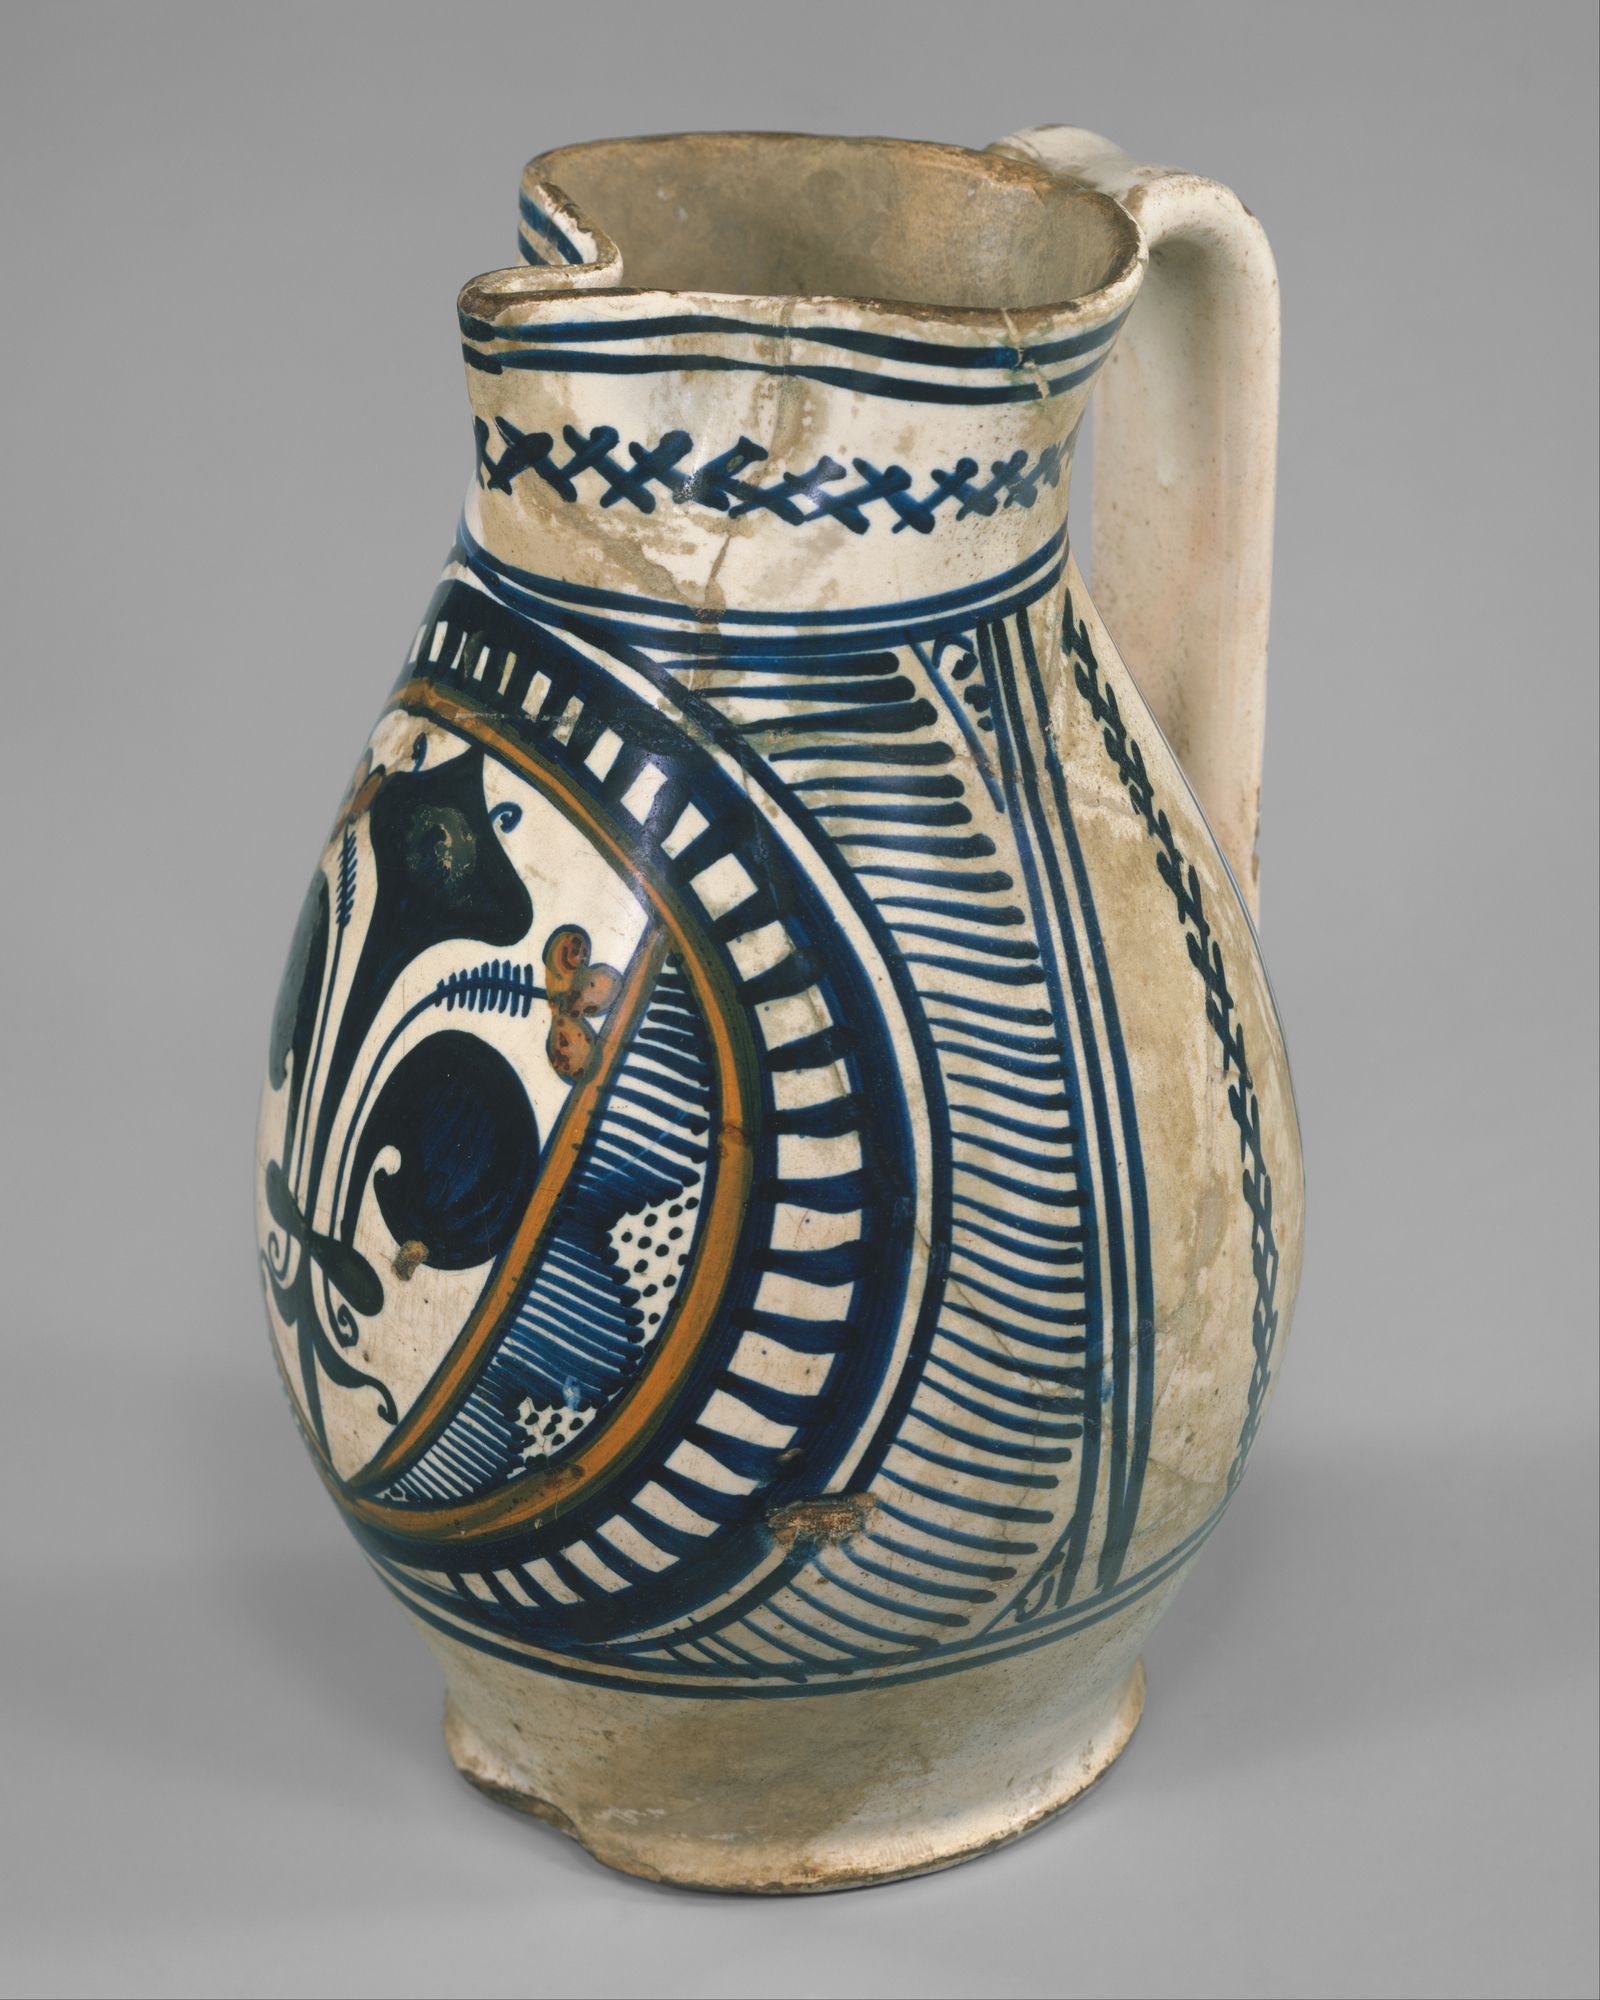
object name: jug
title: Armorial jug (boccale)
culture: italian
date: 1467-1500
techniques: maiolica, glazing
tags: coat of arms